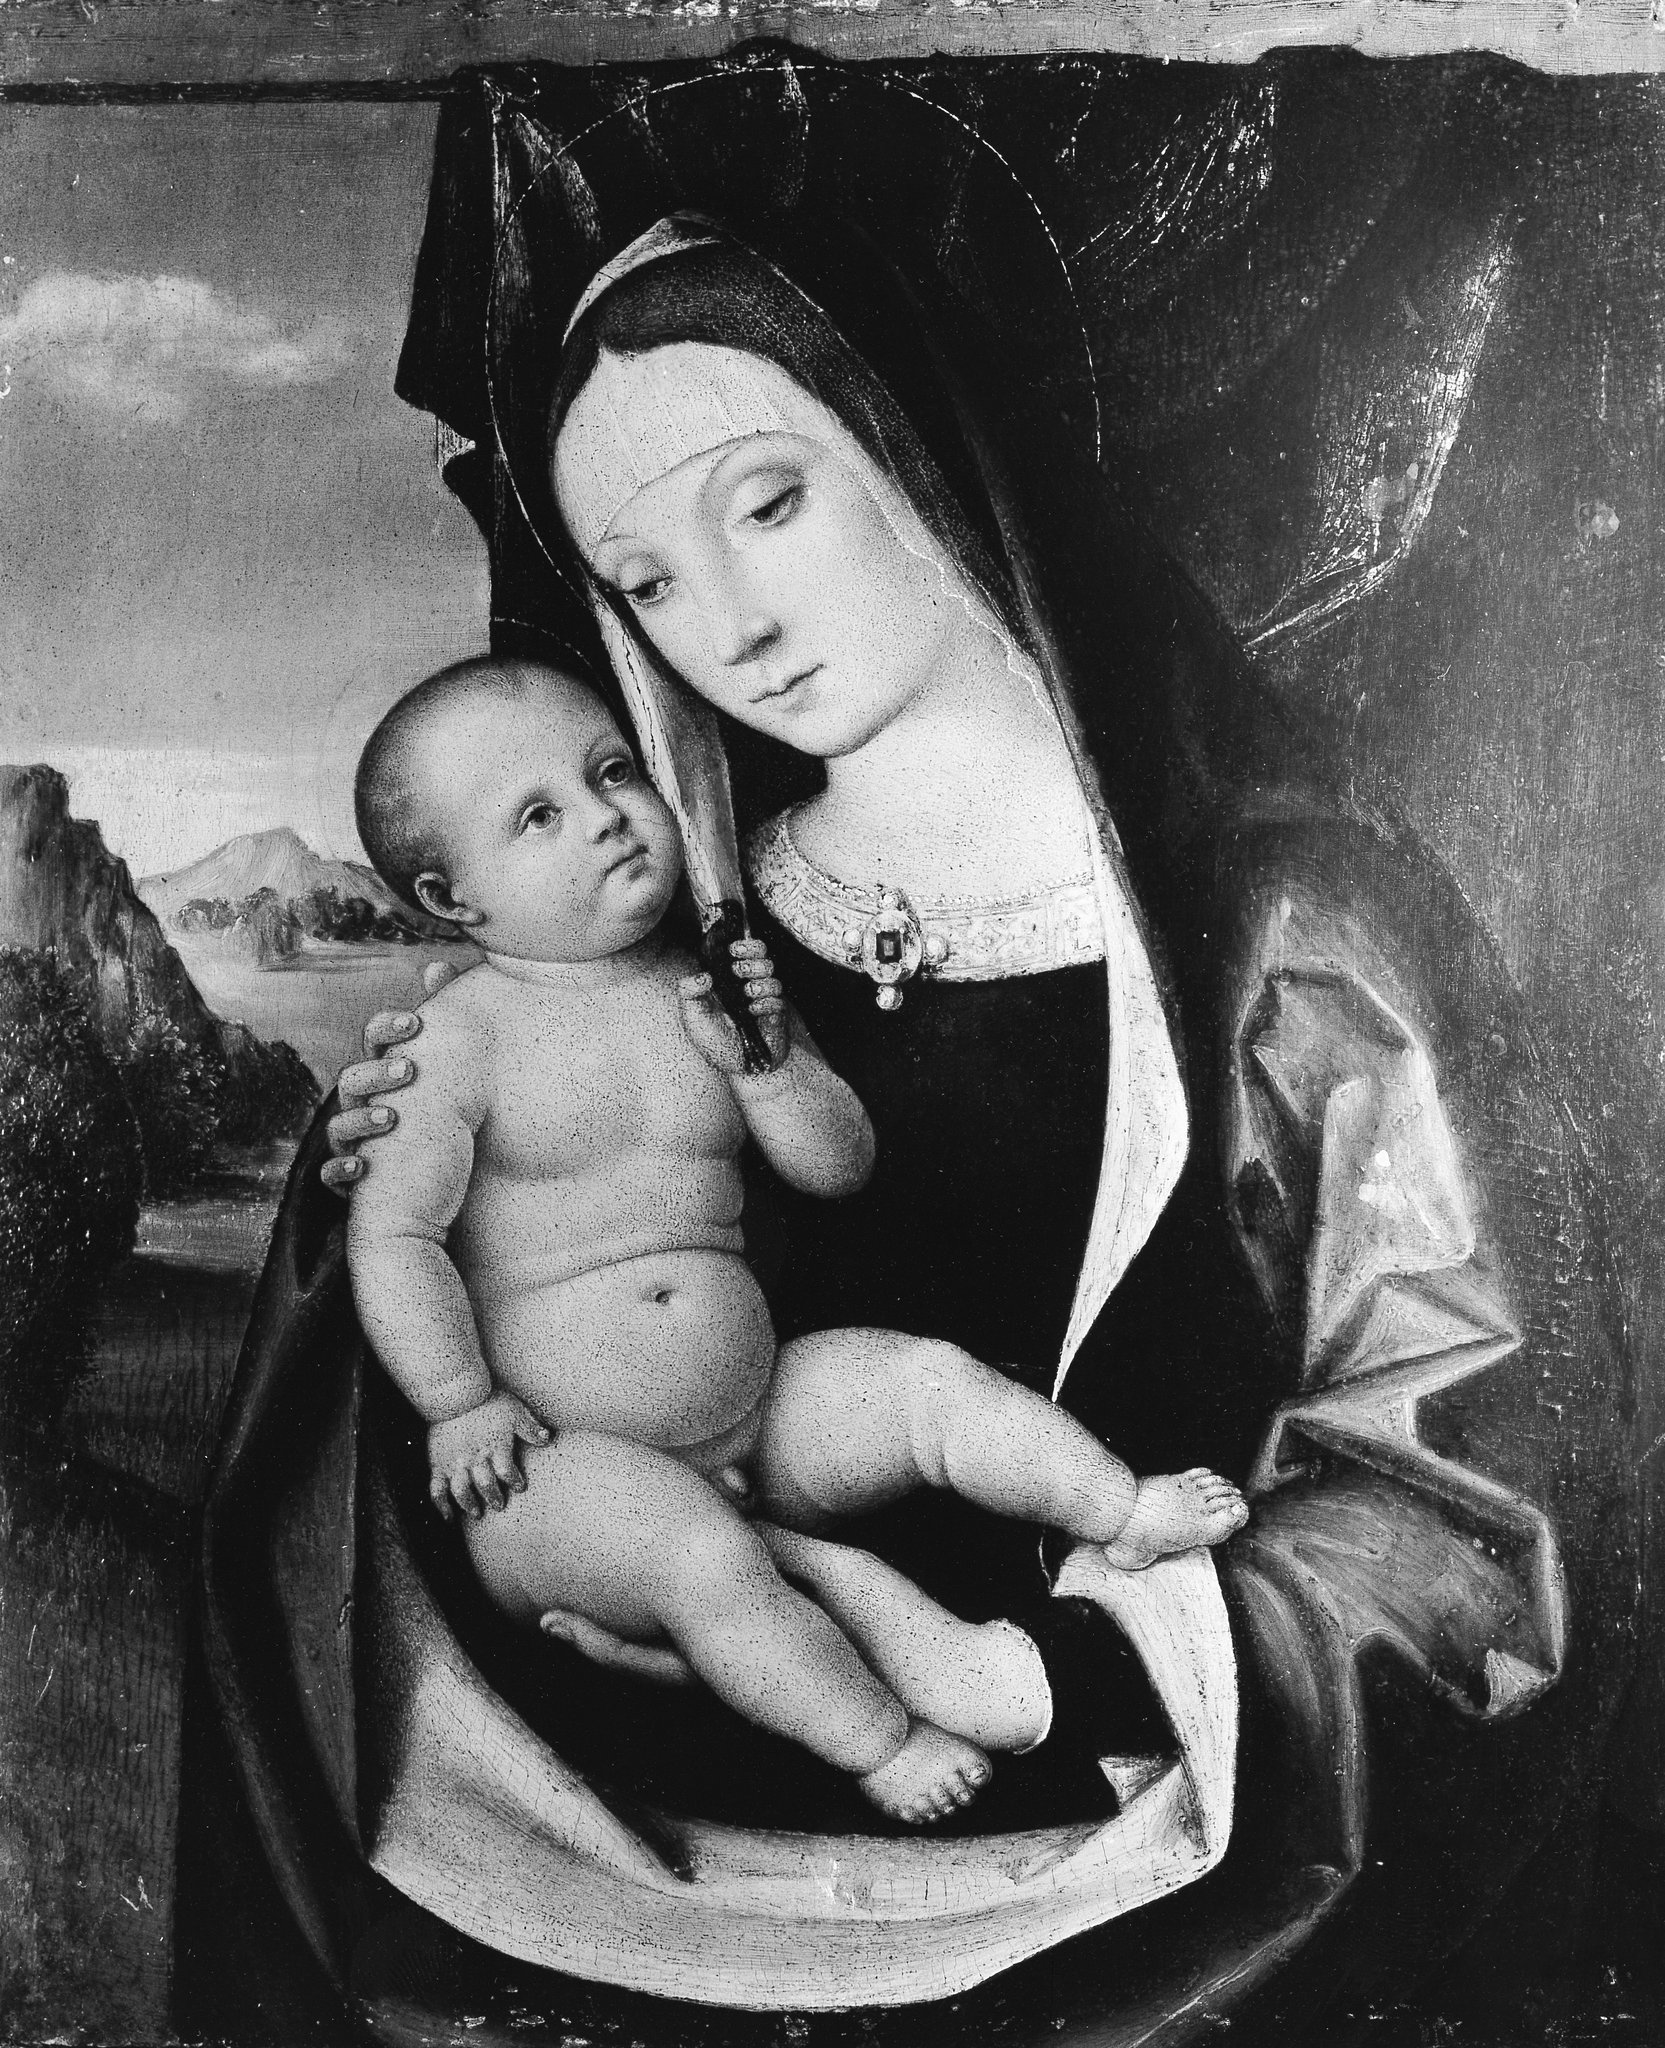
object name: painting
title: Madonna and Child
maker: ercole banci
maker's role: artist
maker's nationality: italian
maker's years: 1500-1529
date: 1500-1529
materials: paint, wood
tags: madonna and child